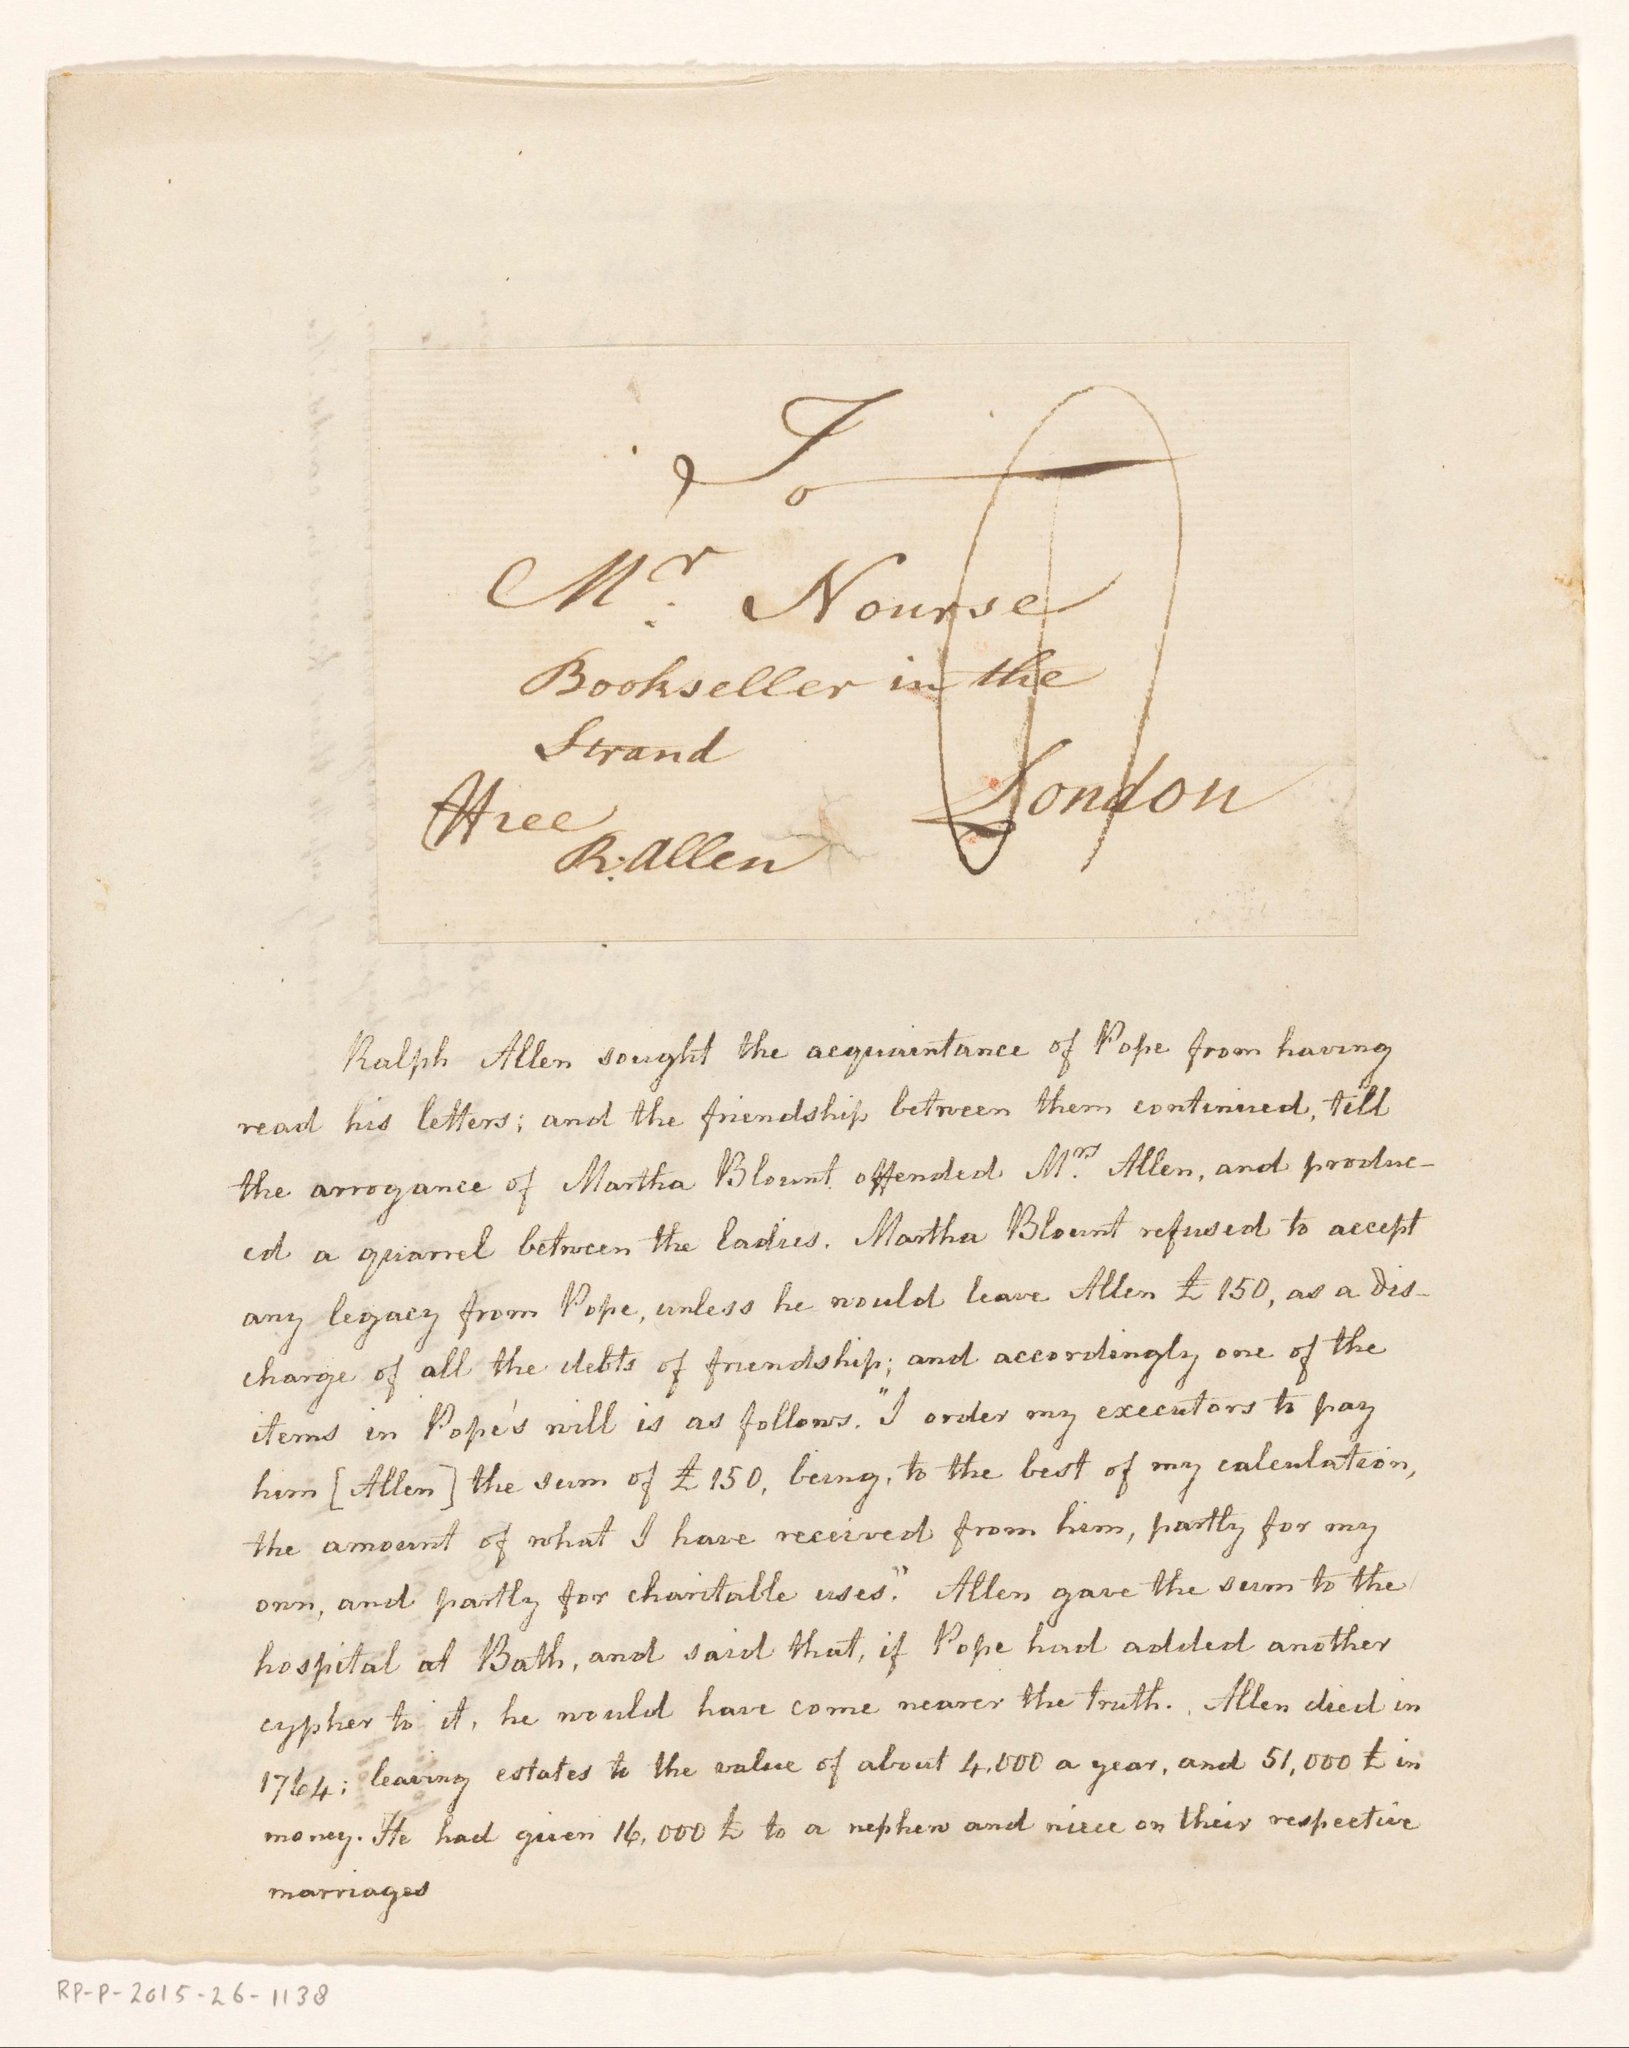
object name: document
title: Aanhef gericht aan boekverkoper Nourse te Londen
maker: ralph allen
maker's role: ondernemer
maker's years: 1693-1764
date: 1730-1764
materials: ink, paper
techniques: pen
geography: bath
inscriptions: collector's mark: Lugt 2228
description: Waarschijnlijk is deze aanhef uitgeknipt uit een groter geheel. In de negentiende-eeuwse beschrijving wordt de schrijver geïdentificeerd als Ralph Allen, ondernemer en magistraat te Bath. De boekverkoper is waarschijnlijk de boekhandelaar John Nourse, hij was gevestigd 138 Strand te Londen. Op verso is een achttiende-eeuws fragment geplakt dat volgens de latere beschrijving betrekking heeft op de politicus John Elwes (1714-1789).